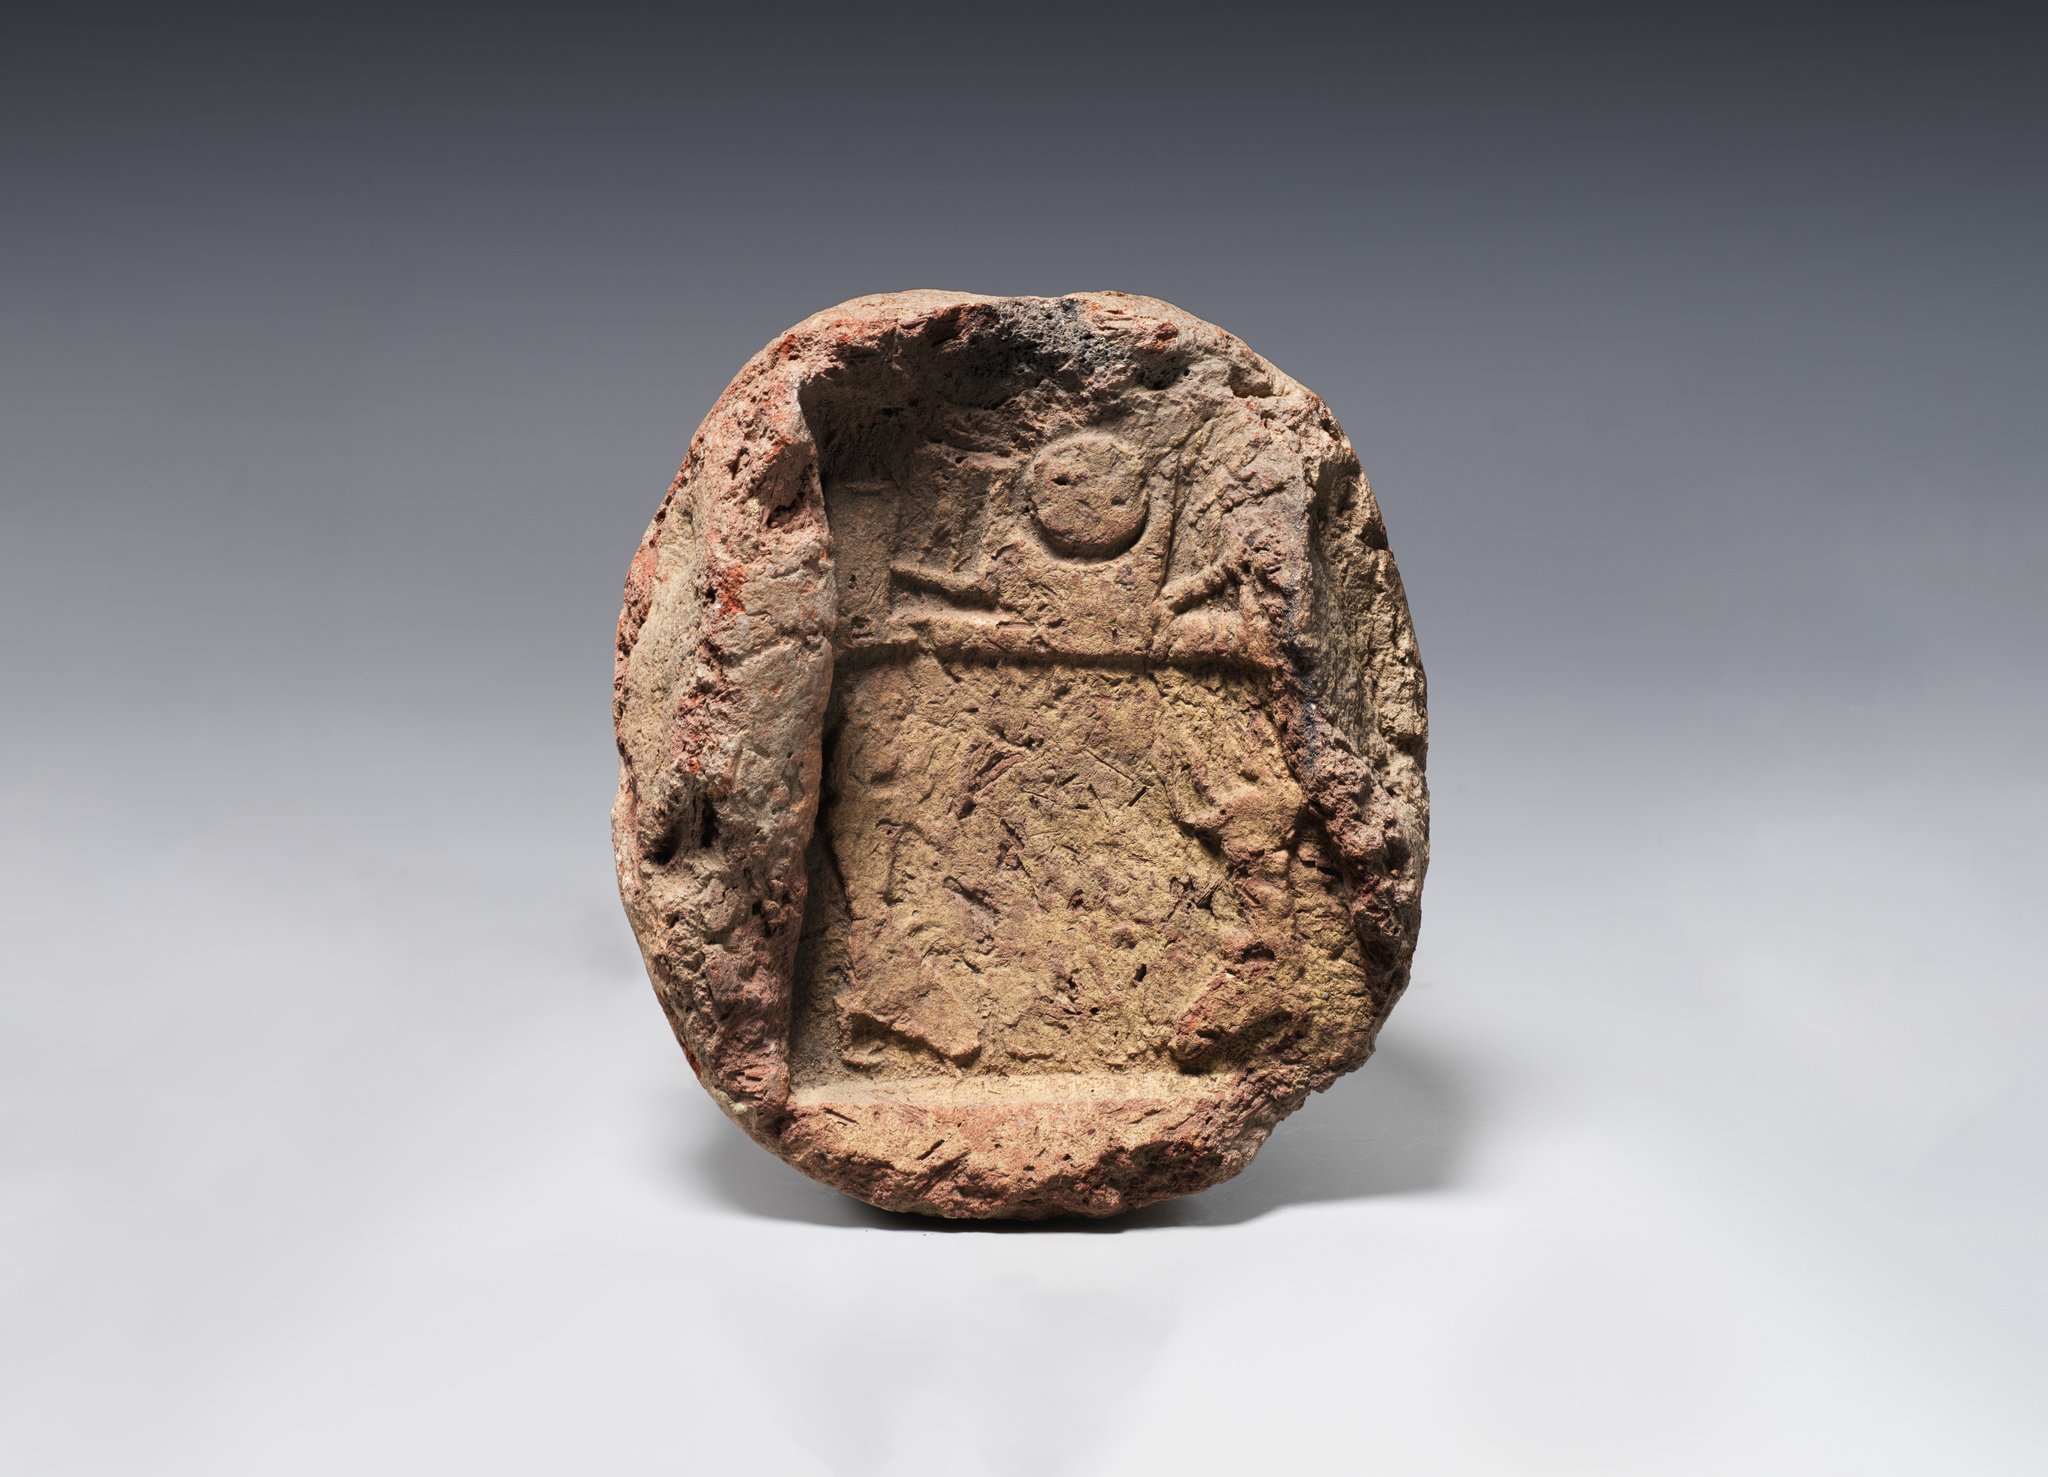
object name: cone, rectangular, amenemhat, divine adoratrice, wardrobe, chamberlain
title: Funerary Cone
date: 712-525 BCE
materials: pottery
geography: egypt